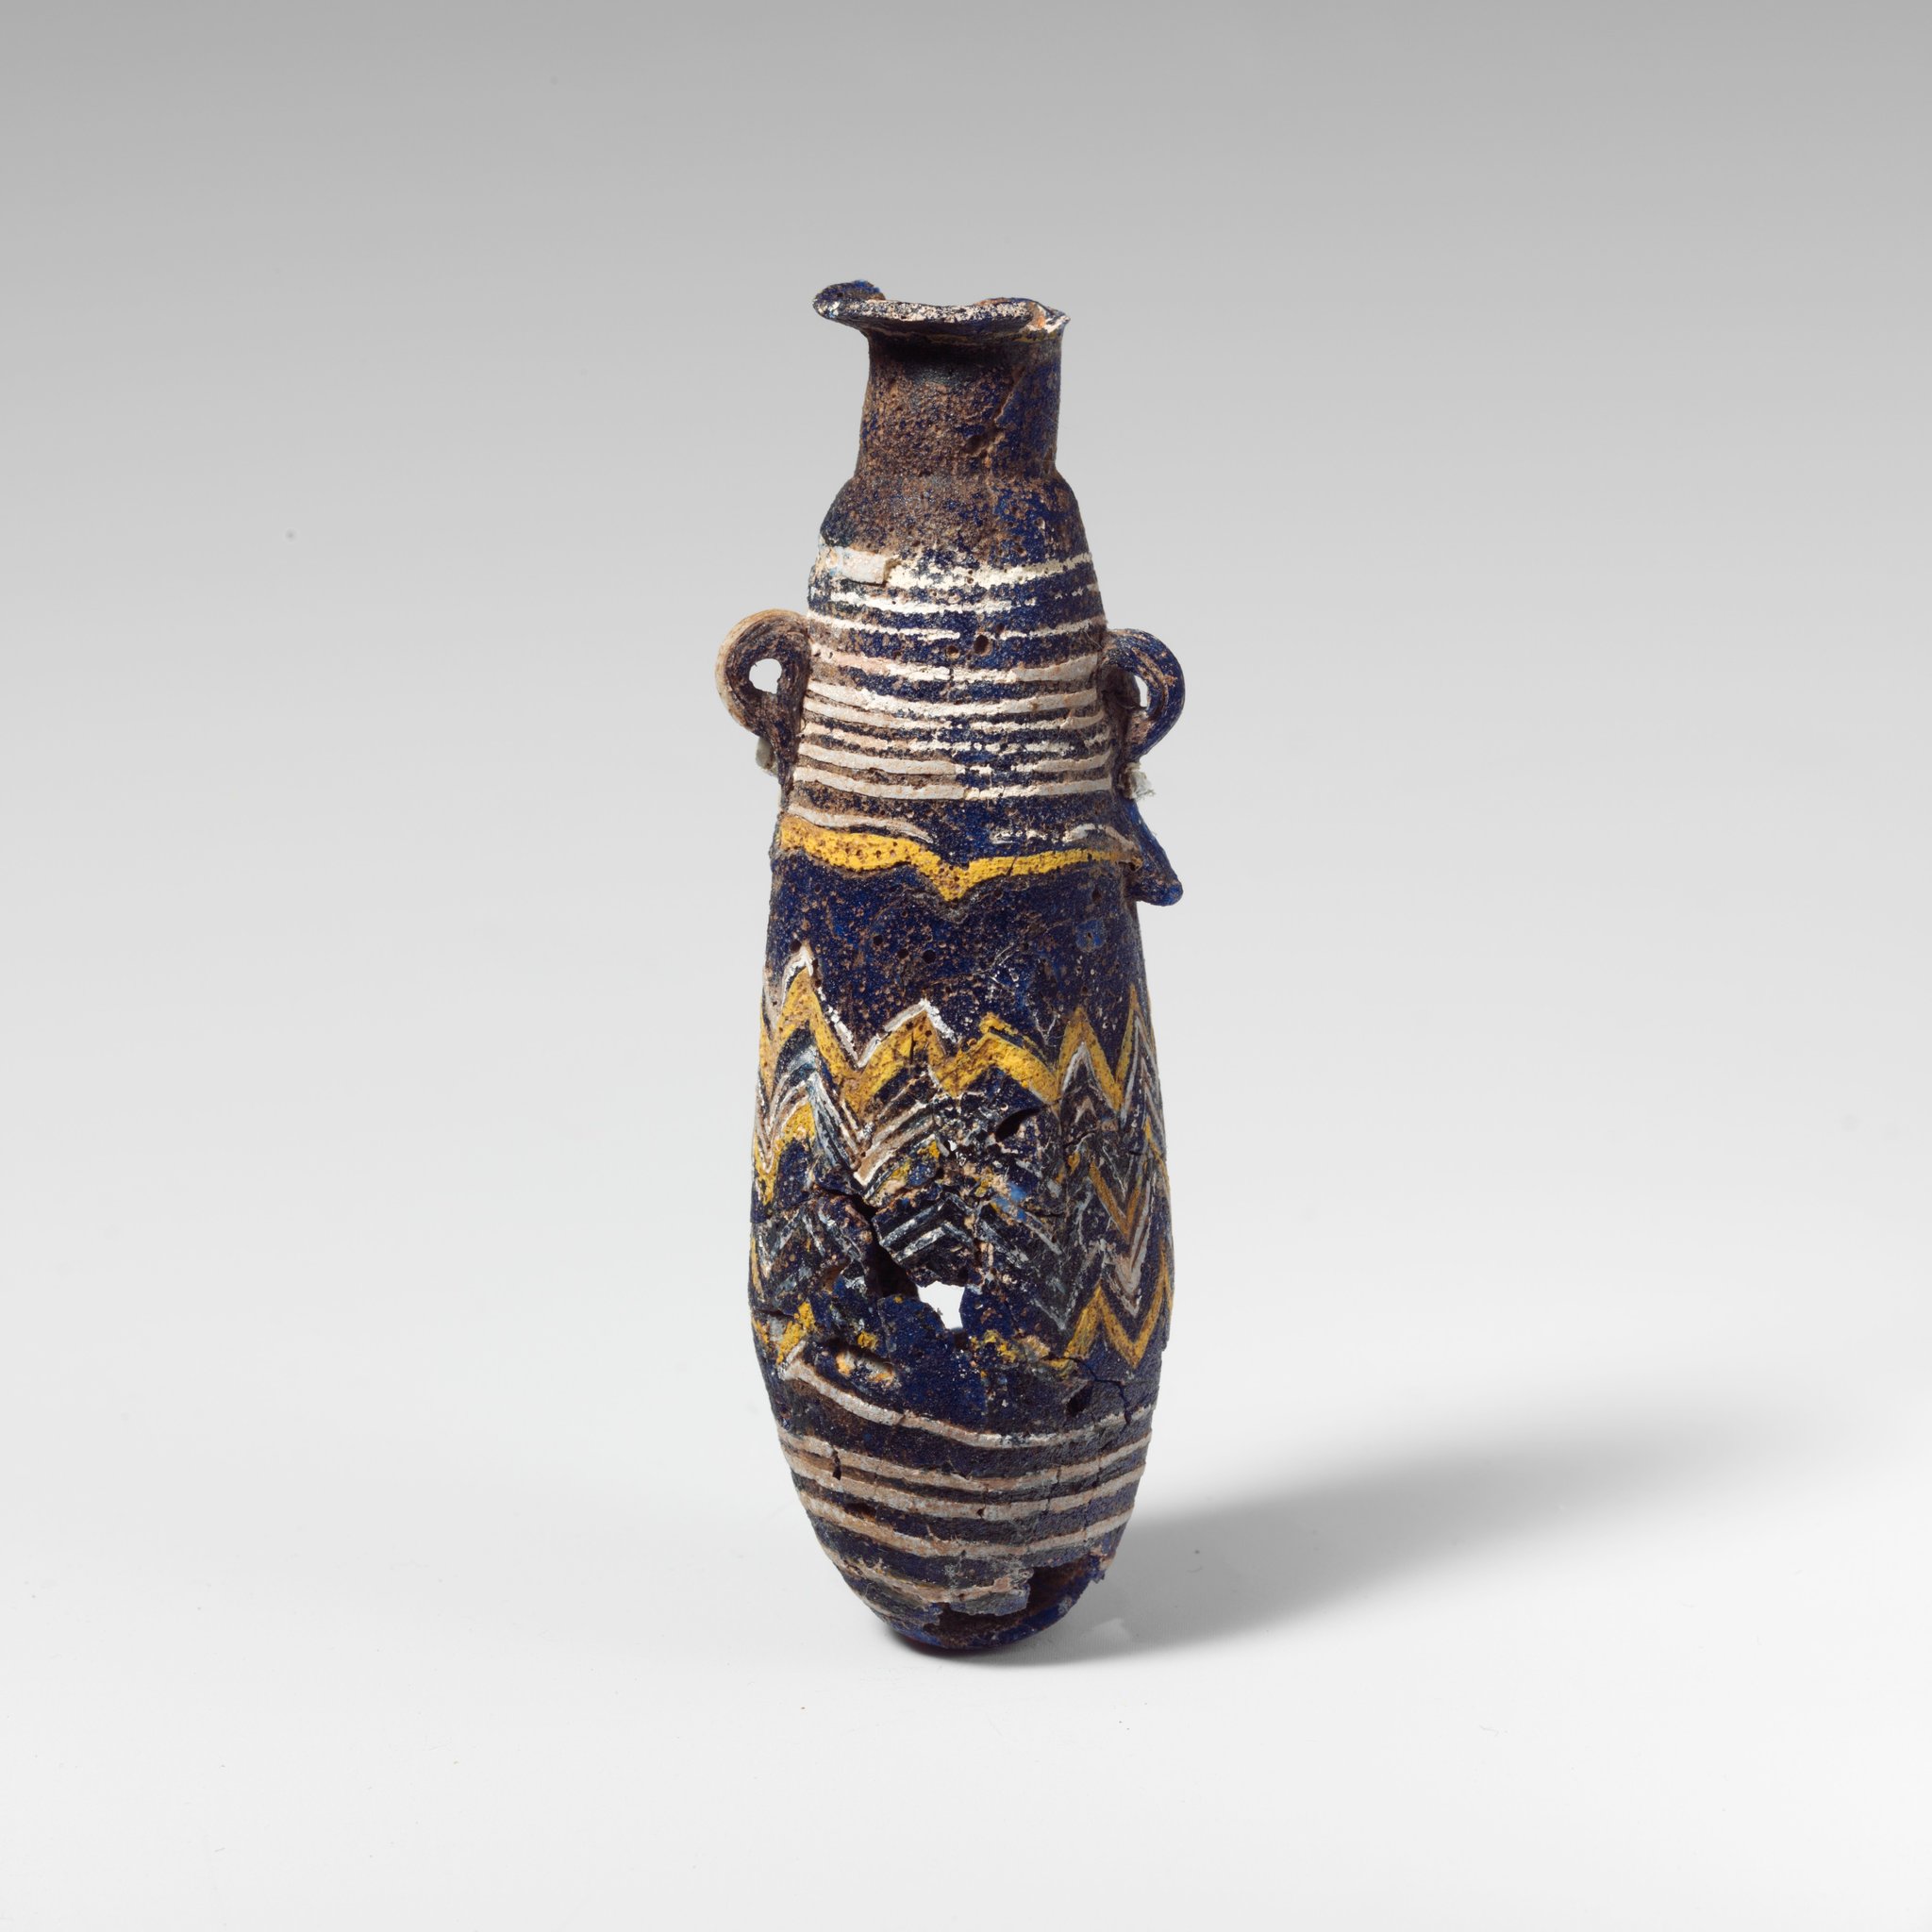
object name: alabastron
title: Glass alabastron (perfume bottle)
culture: greek, eastern mediterranean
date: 534-401 BCE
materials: glass